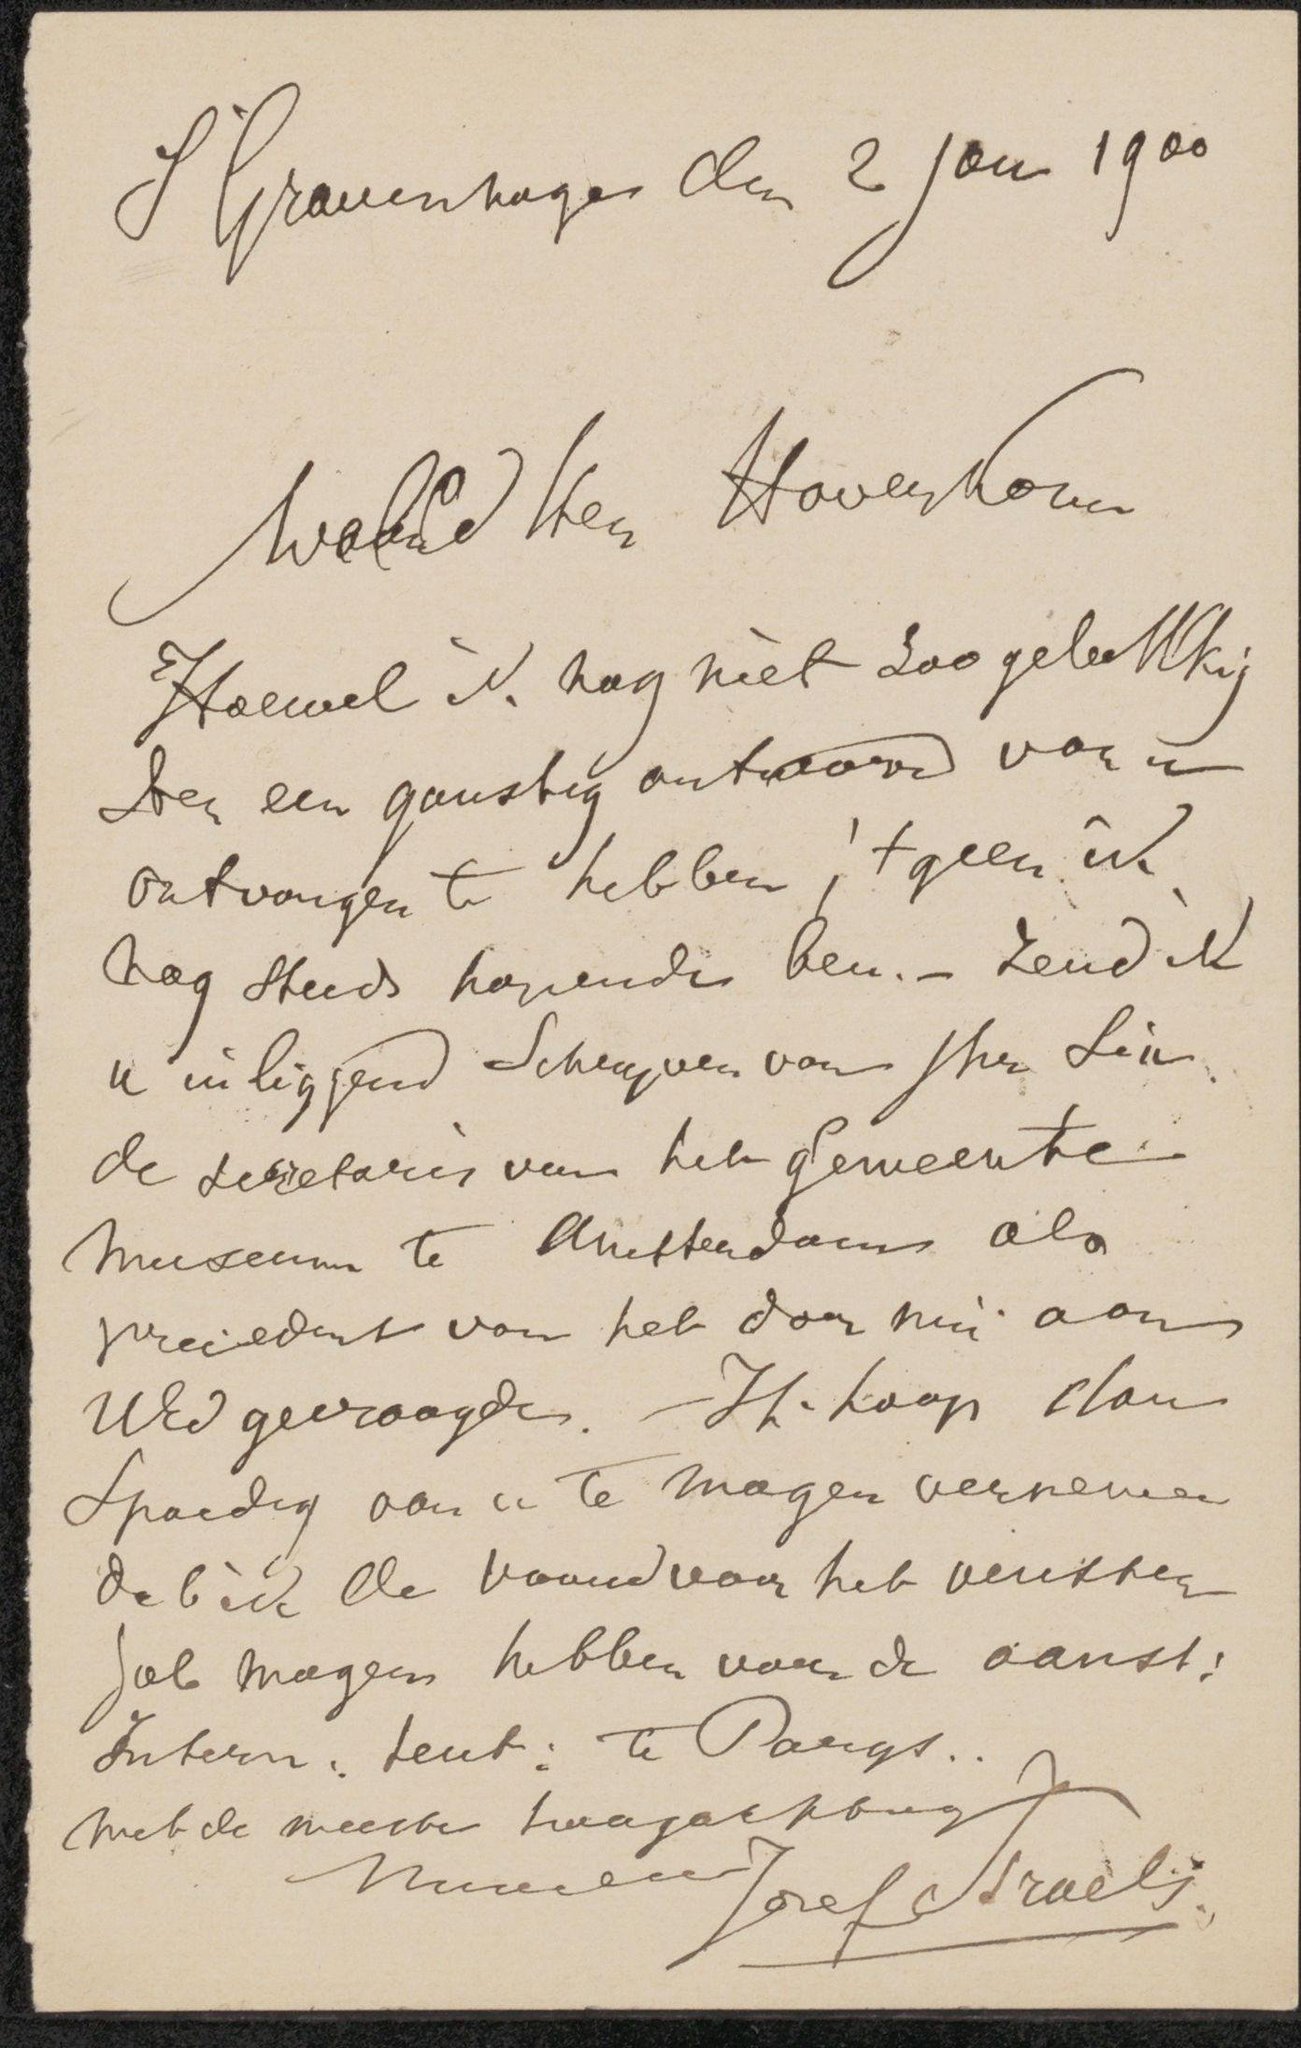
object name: letter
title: Brief aan Pieter Haverkorn van Rijsewijk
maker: jozef israëls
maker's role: draughtsman, painter, print maker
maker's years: 1824-1911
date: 1900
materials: ink, paper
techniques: pen, writing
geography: the hague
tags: museum, amsterdam, jonkheer jan six, pieter haverkorn van rijsewijk, paris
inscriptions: collector's mark: ‘RPK’, watermark